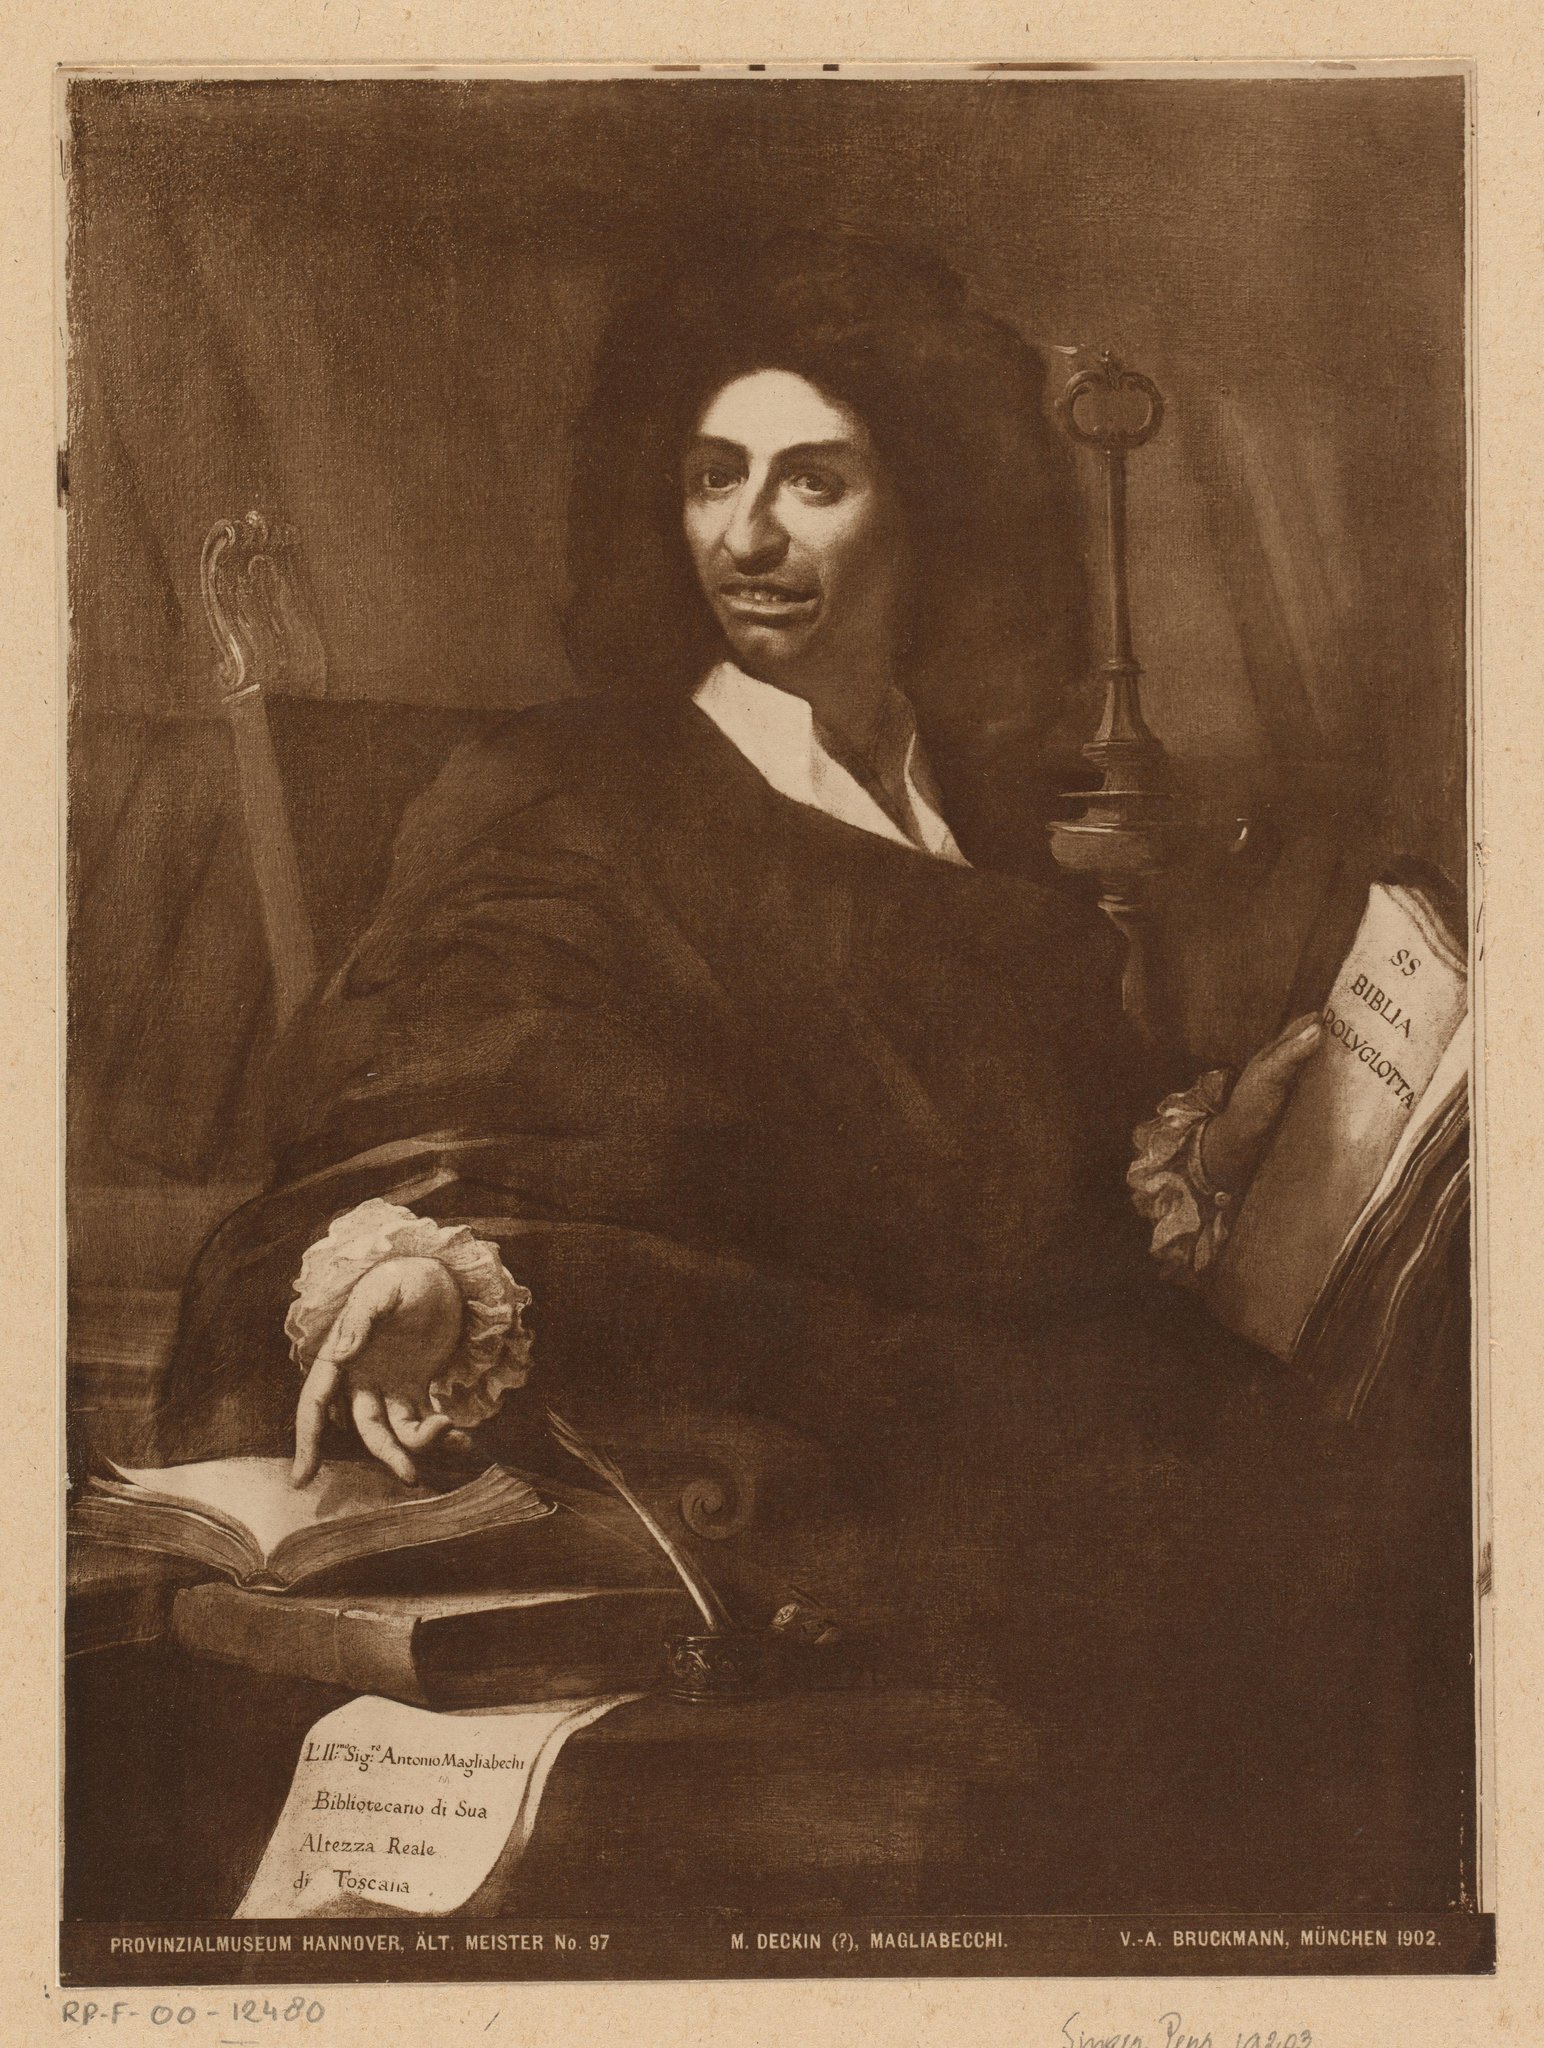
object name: photomechanical print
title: Reproductie van een geschilderd portret van Antonio Magliabecchi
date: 1902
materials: paper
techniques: photograph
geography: munich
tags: historical persons, politician, e.g. party leader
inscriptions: inscription: ‘PROVINZIALMUSEUM HANNOVER, ÄLT. MEISTER No. 97’